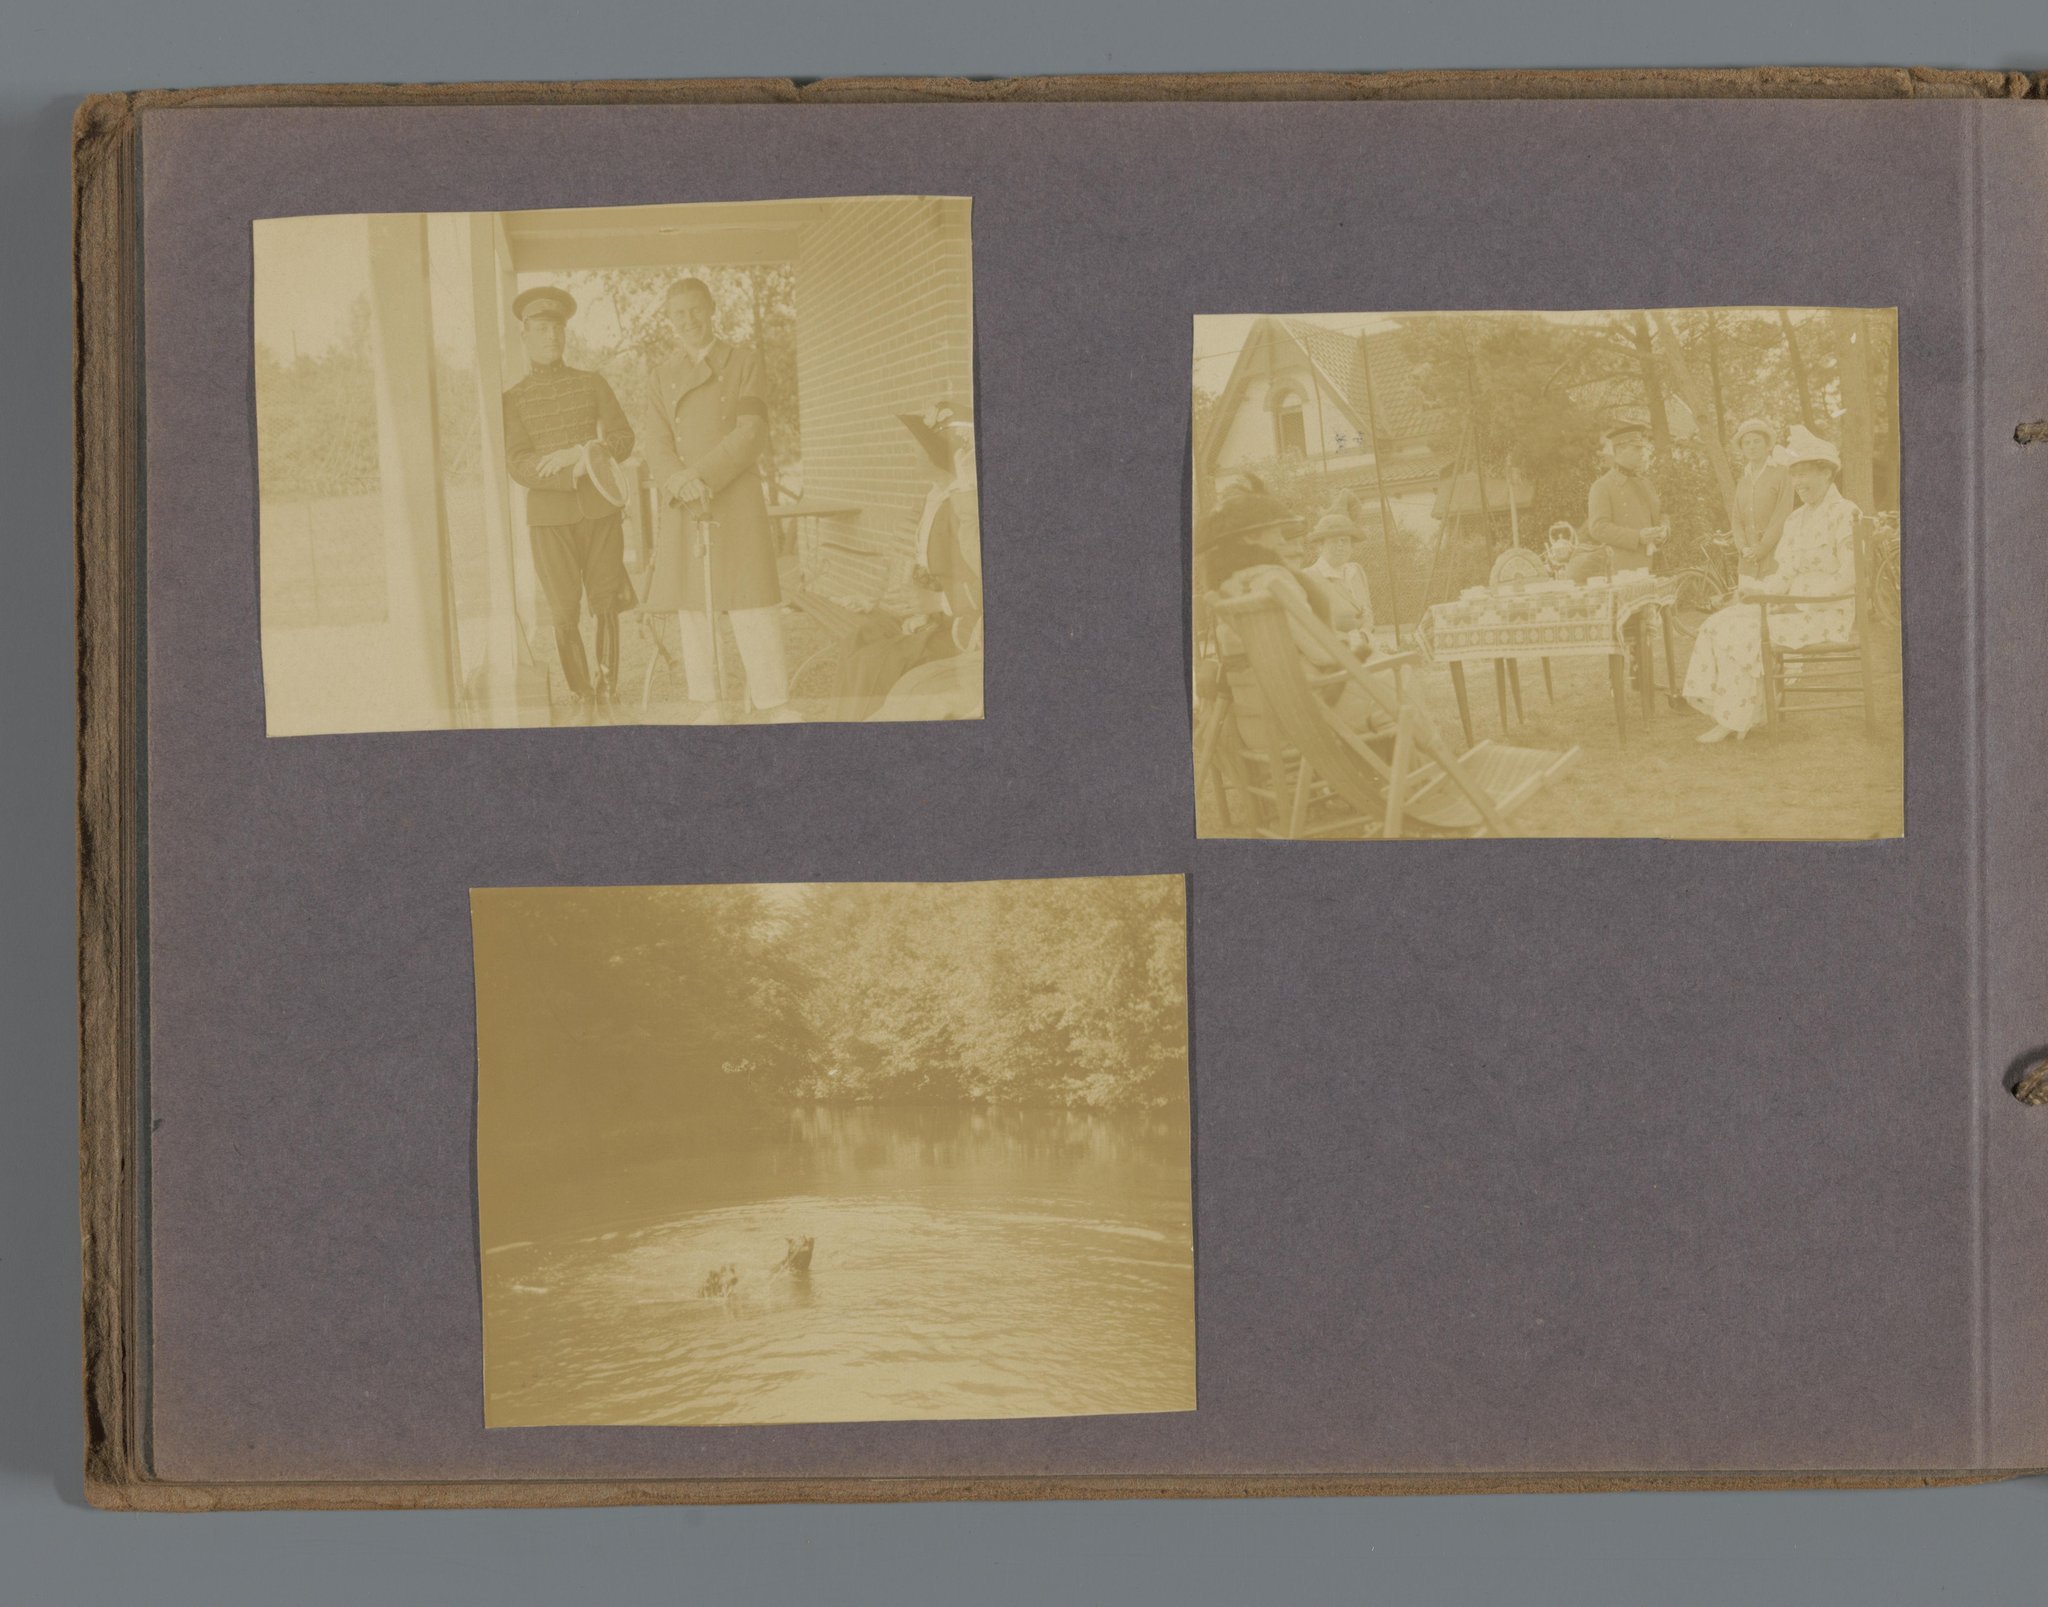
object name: photograph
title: Vrienden of familie van het gezin Onnen-van den Berg, buiten bij een woonhuis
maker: carolina frederika onnen (lien/loen)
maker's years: 1896-1983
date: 1914-1915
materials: paper, cardboard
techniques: gelatin silver print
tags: family life, friends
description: Deze foto's zijn onderdeel van een album.